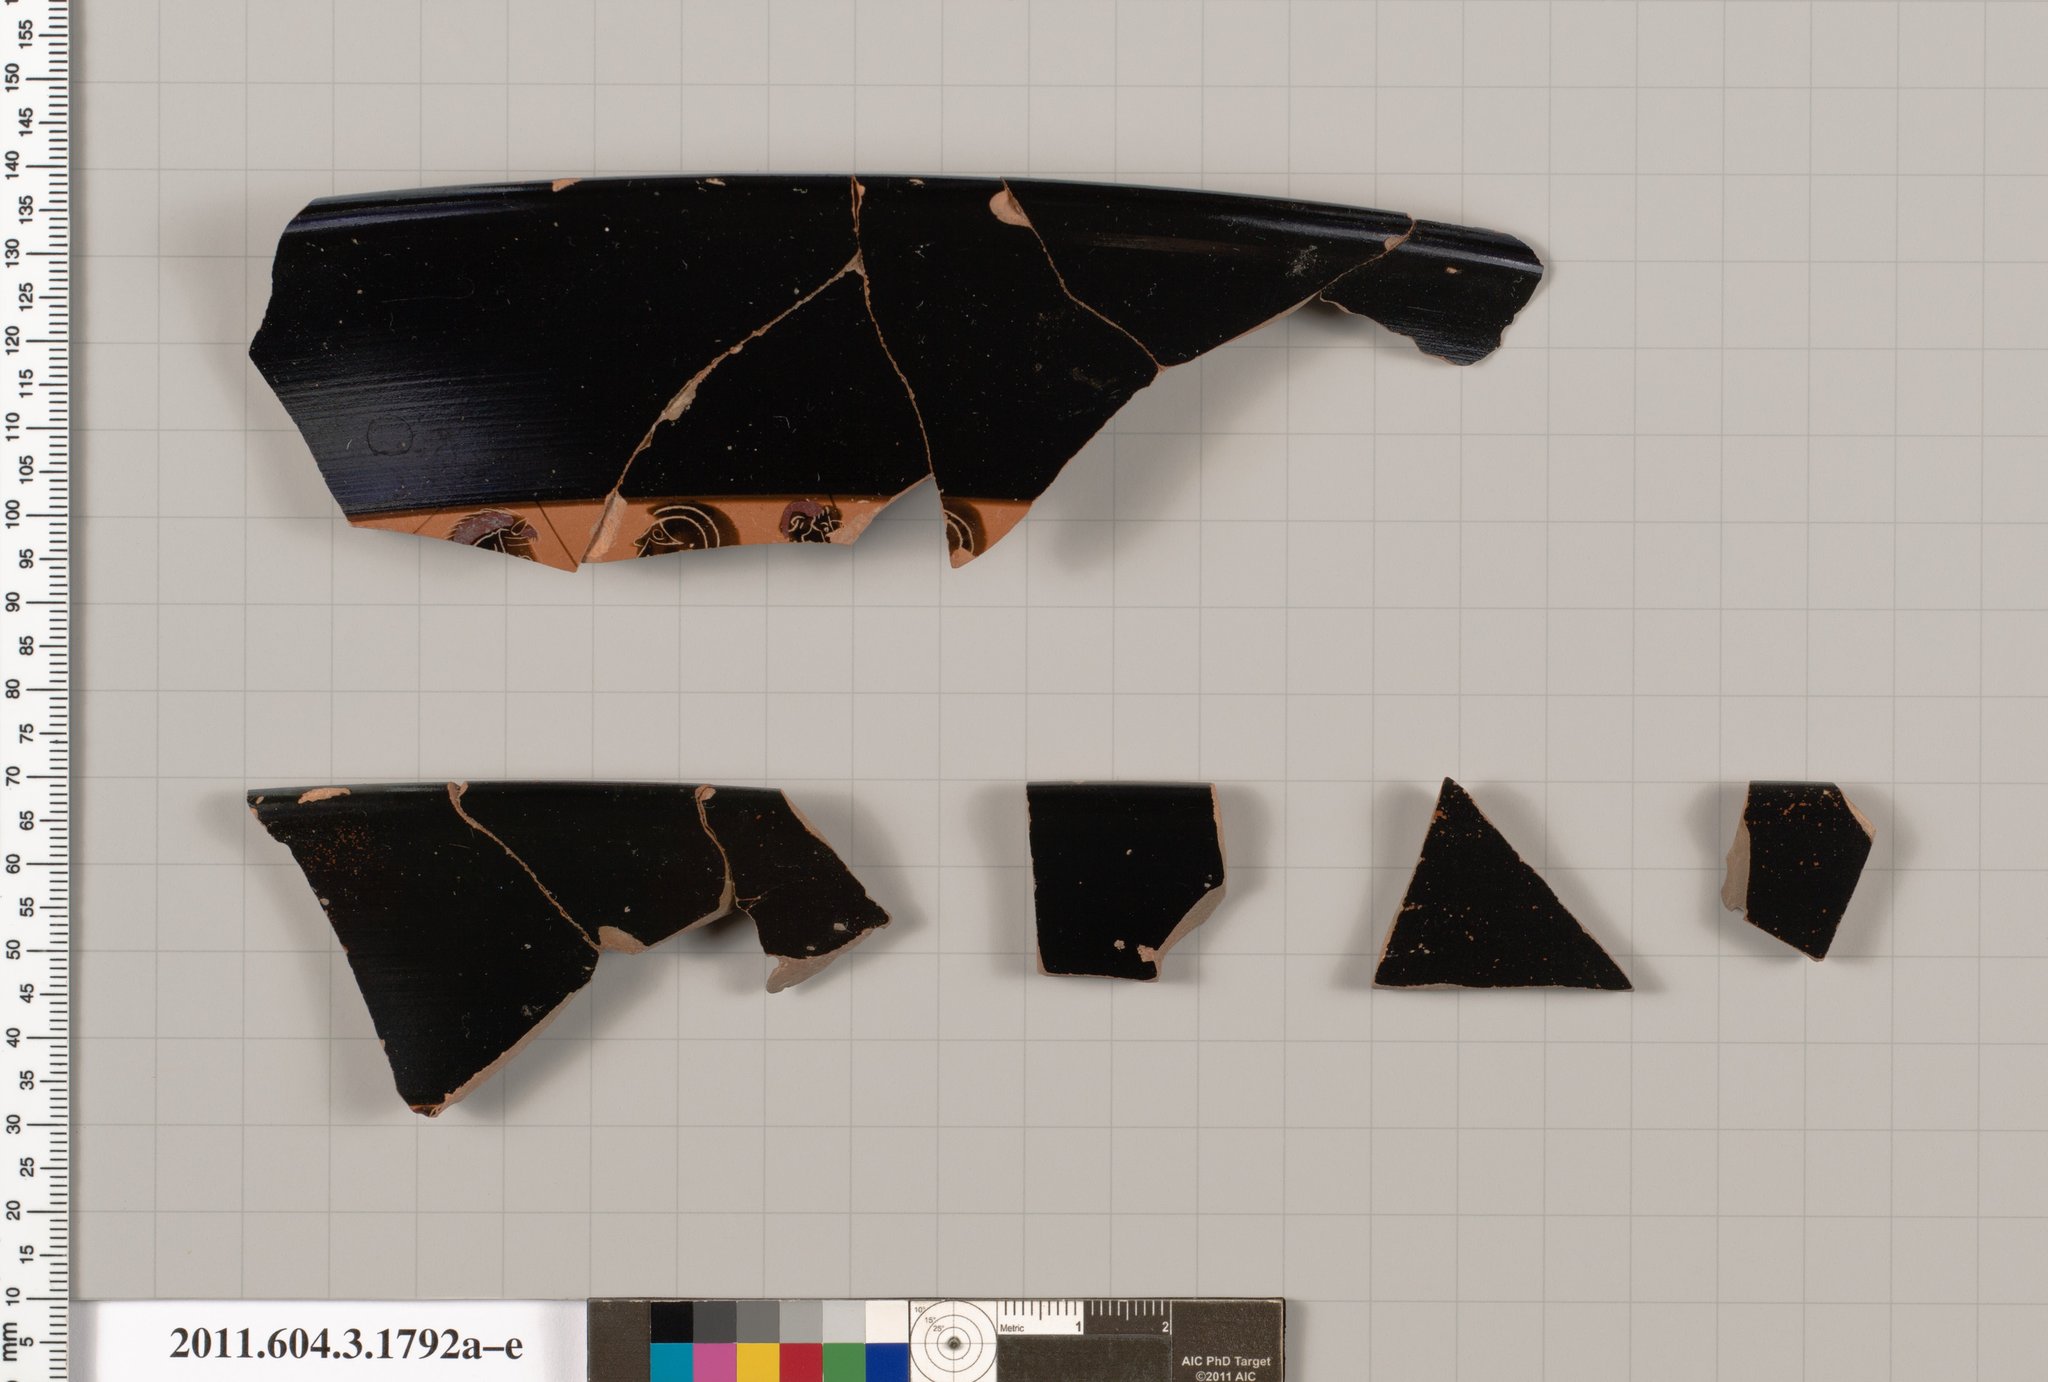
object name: kylix fragment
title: Terracotta fragments of a kylix: Band cup (drinking cup)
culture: greek, attic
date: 560-540 BCE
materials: terracotta